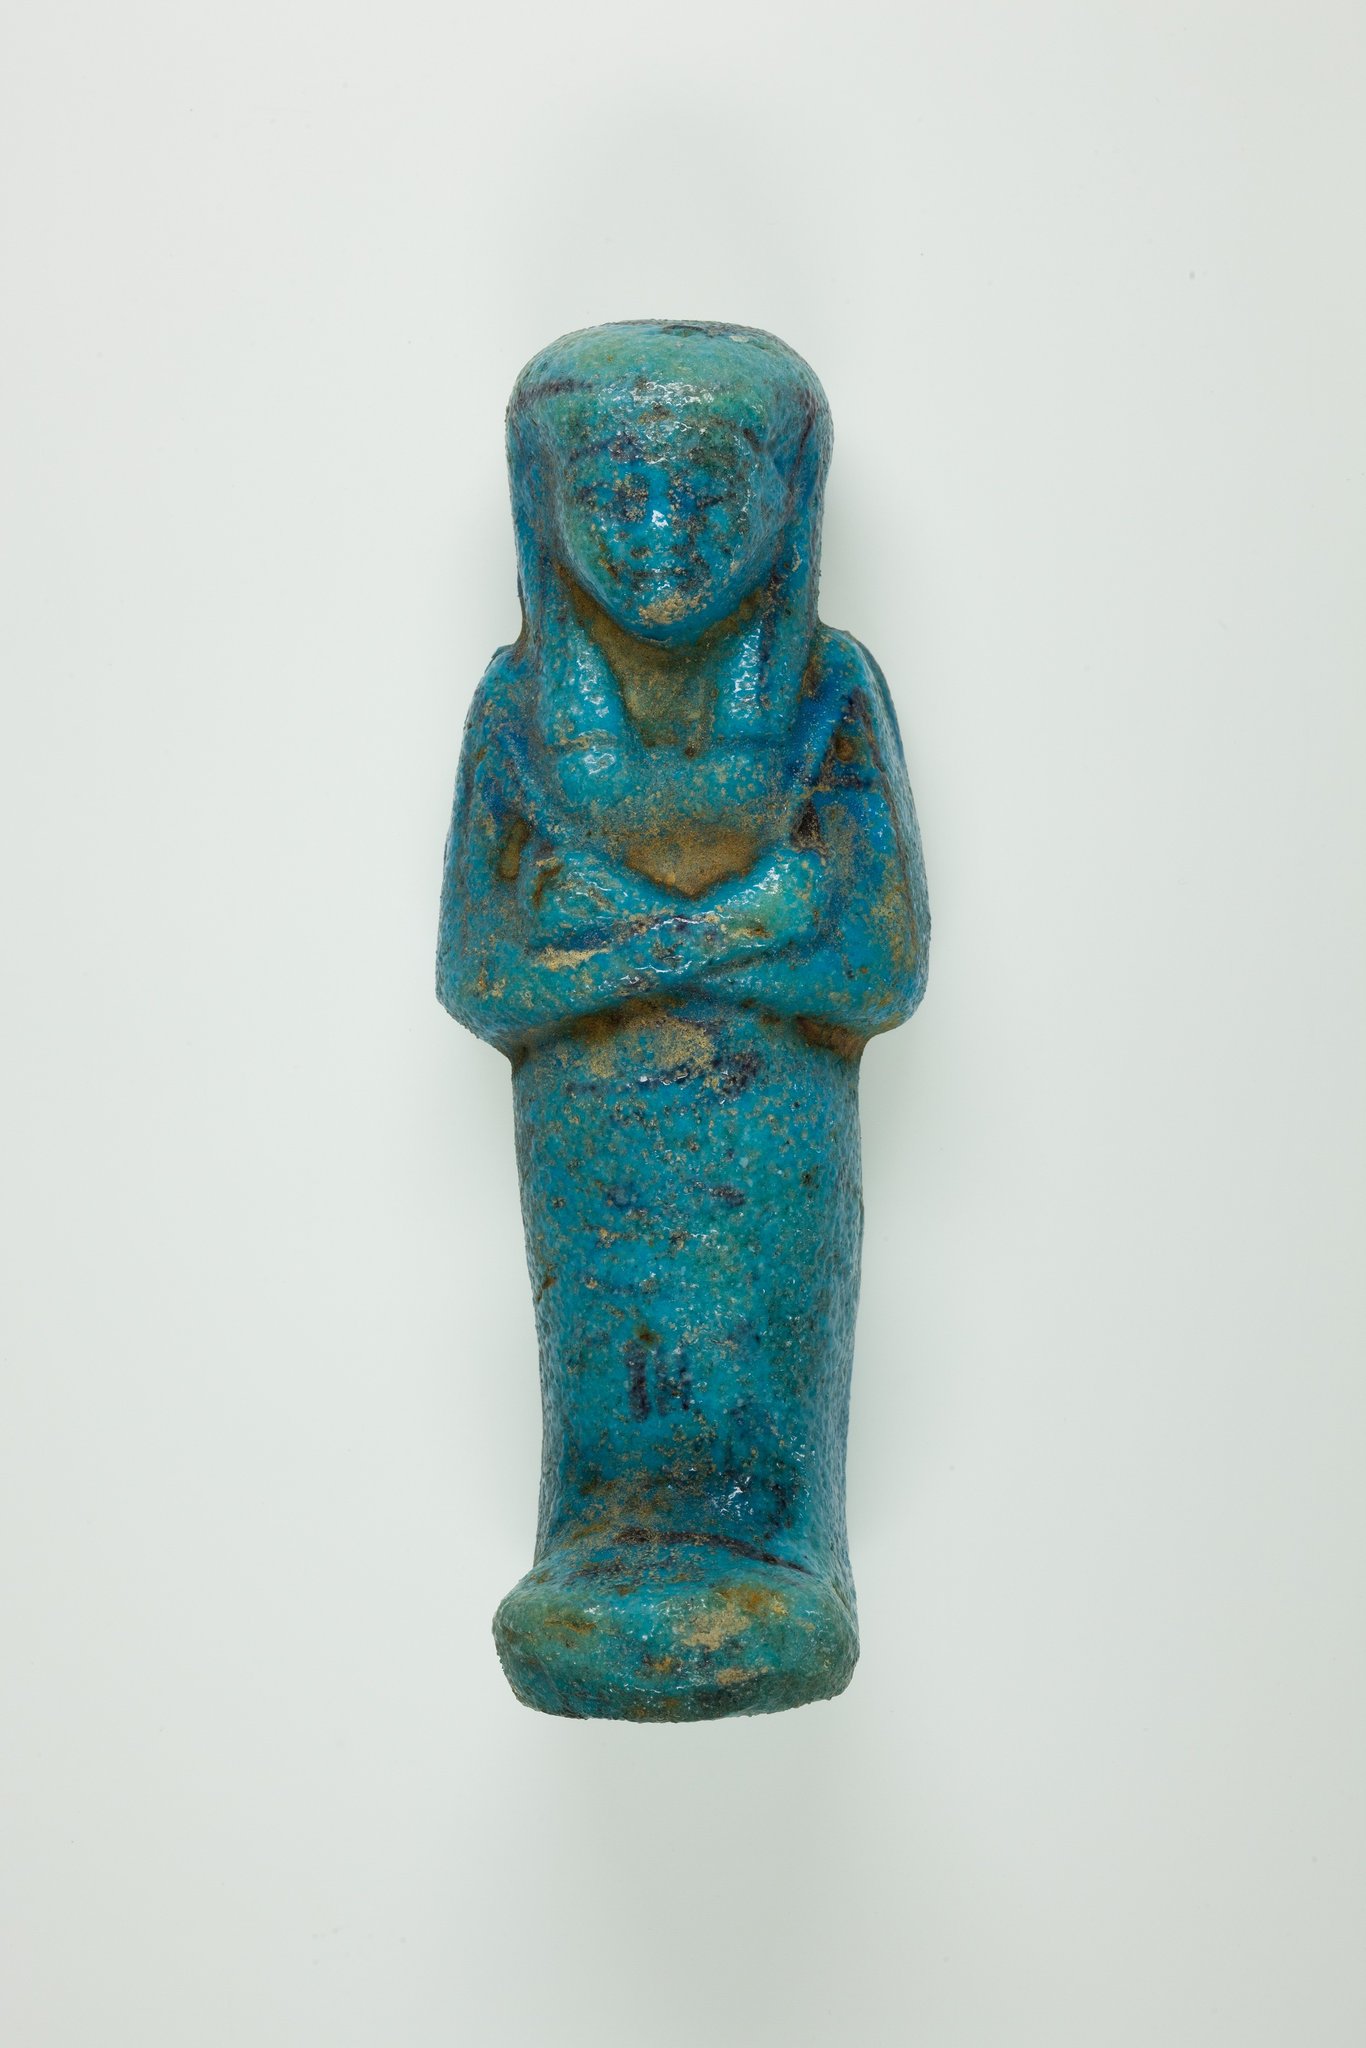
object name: worker shabti, henettawy c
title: Worker Shabti of Henettawy (C), Daughter of Isetemkheb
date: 990-970 BCE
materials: faience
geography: egypt